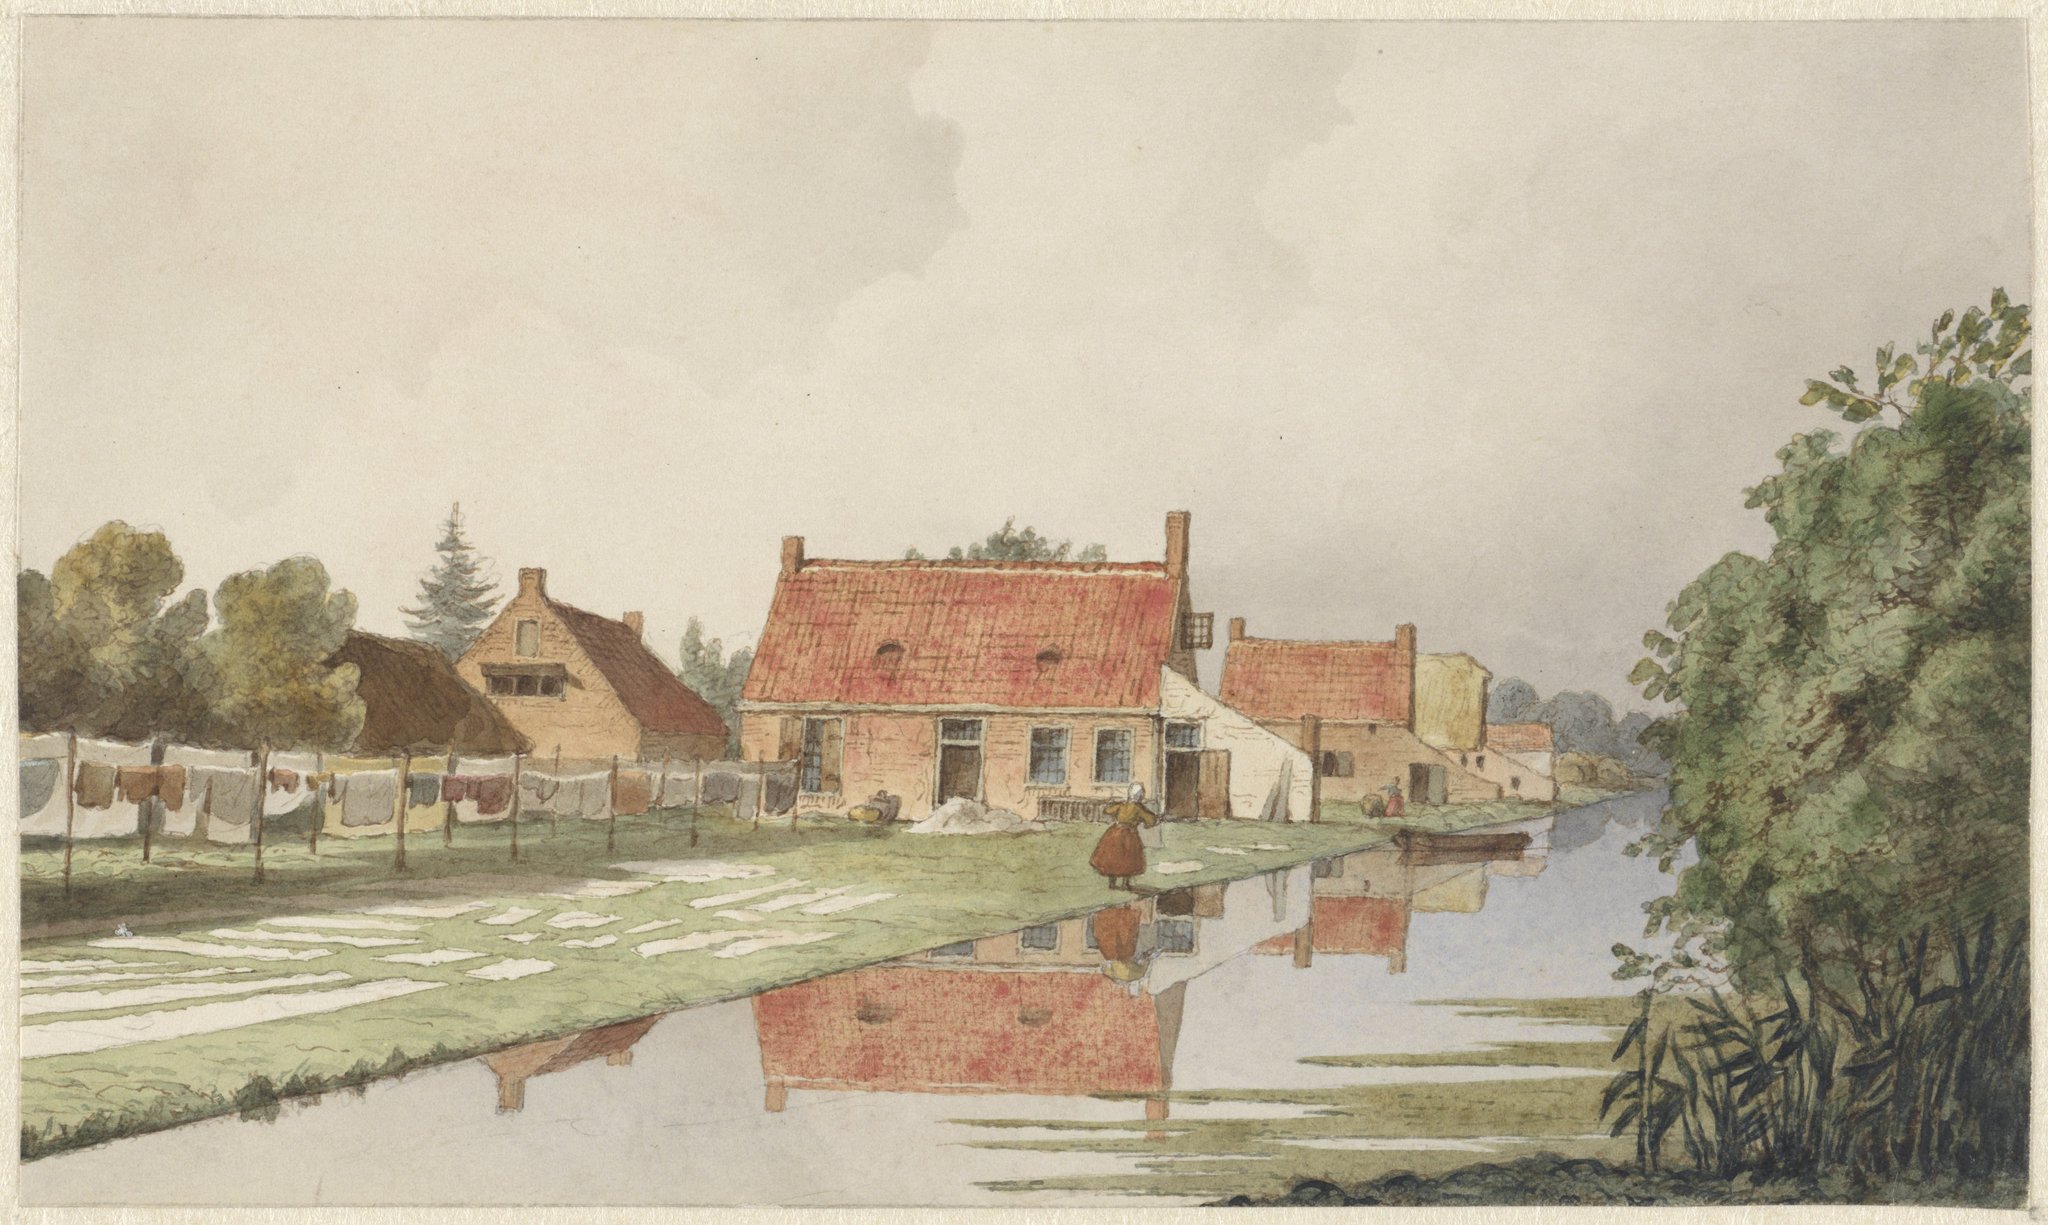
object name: watercolor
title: Blekerijen achter een vaart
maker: hendrik abraham klinkhamer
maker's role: draughtsman, painter, print maker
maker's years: 1810-1872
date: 1820-1872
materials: ink, paper, pencil, watercolor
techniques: brush, pen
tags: cleaning of material by bleaching, bleaching (laundering)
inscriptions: inscription: ‘Agter Zandhoeven’